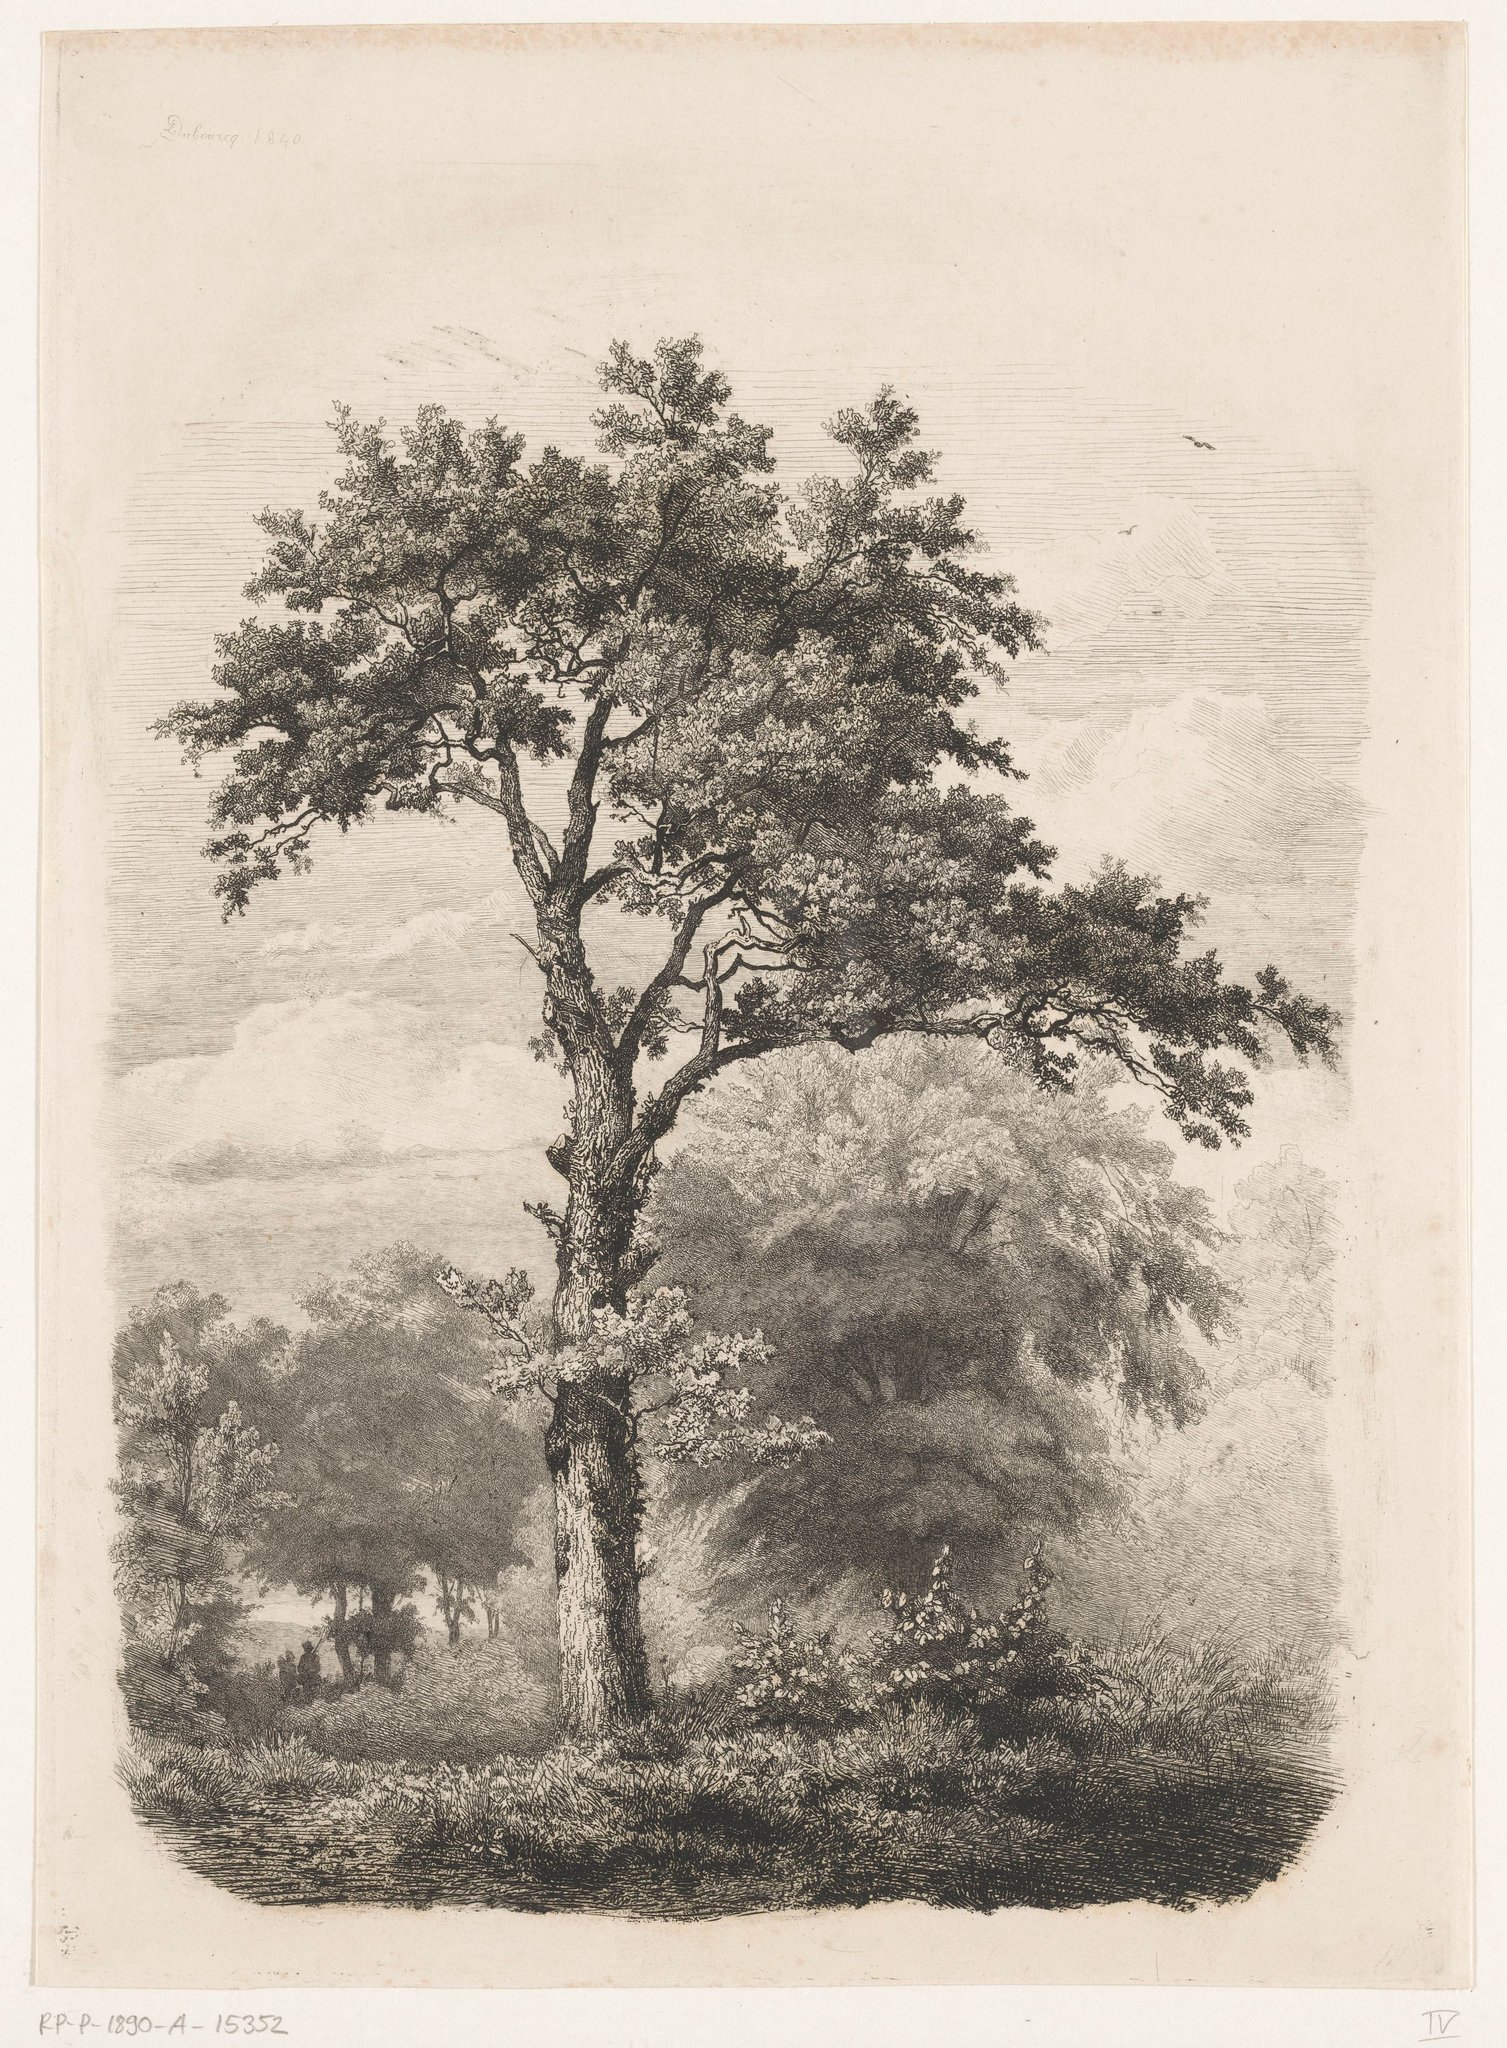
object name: print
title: Vrijstaande loofboom in landschap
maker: pierre louis dubourcq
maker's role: draughtsman, painter, print maker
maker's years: 1815-1873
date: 1840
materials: paper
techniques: drypoint, etching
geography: netherlands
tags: trees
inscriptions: collector's mark: Lugt 2228